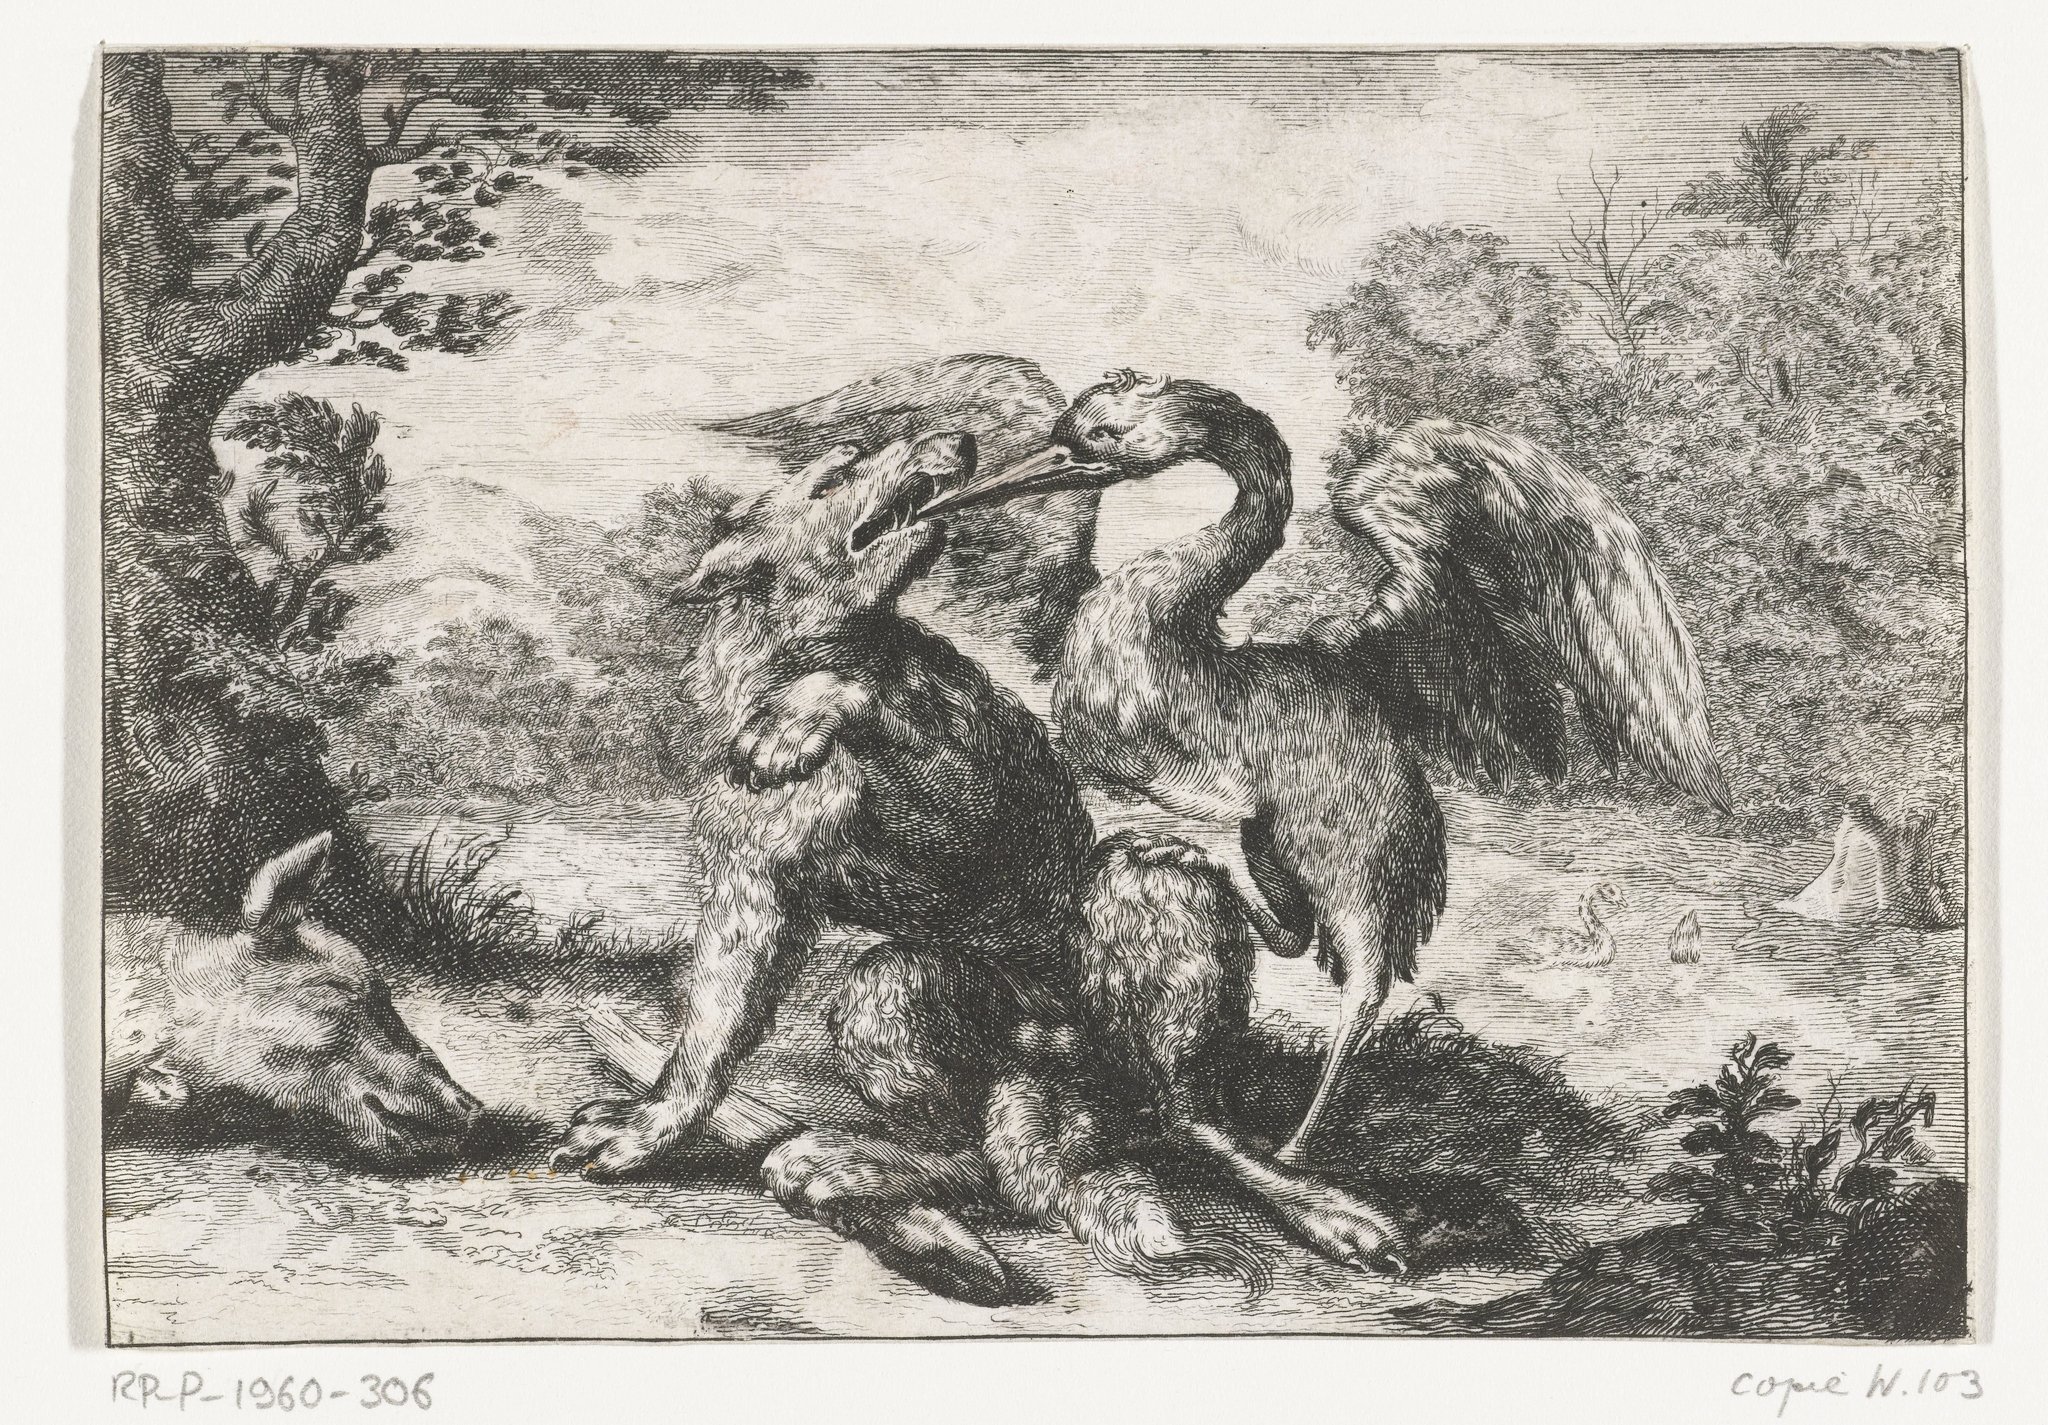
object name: print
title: Wolf en kraanvogel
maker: Anonymous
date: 1655-1740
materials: paper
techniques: etching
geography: netherlands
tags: shore-birds and wading-birds: crane, fables of aesop : use 85(...), beasts of prey, predatory animals: wolf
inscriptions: collector's mark: Lugt 2228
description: Een kraanvogel haalt met zijn snavel een botje uit de hals van een wolf. De wolf had een schaap buit gemaakt en bij het opeten ervan was een botje in zijn hals blijven steken. Deze voorstelling illustreert een verhaal uit de fabelen van Aesopus.